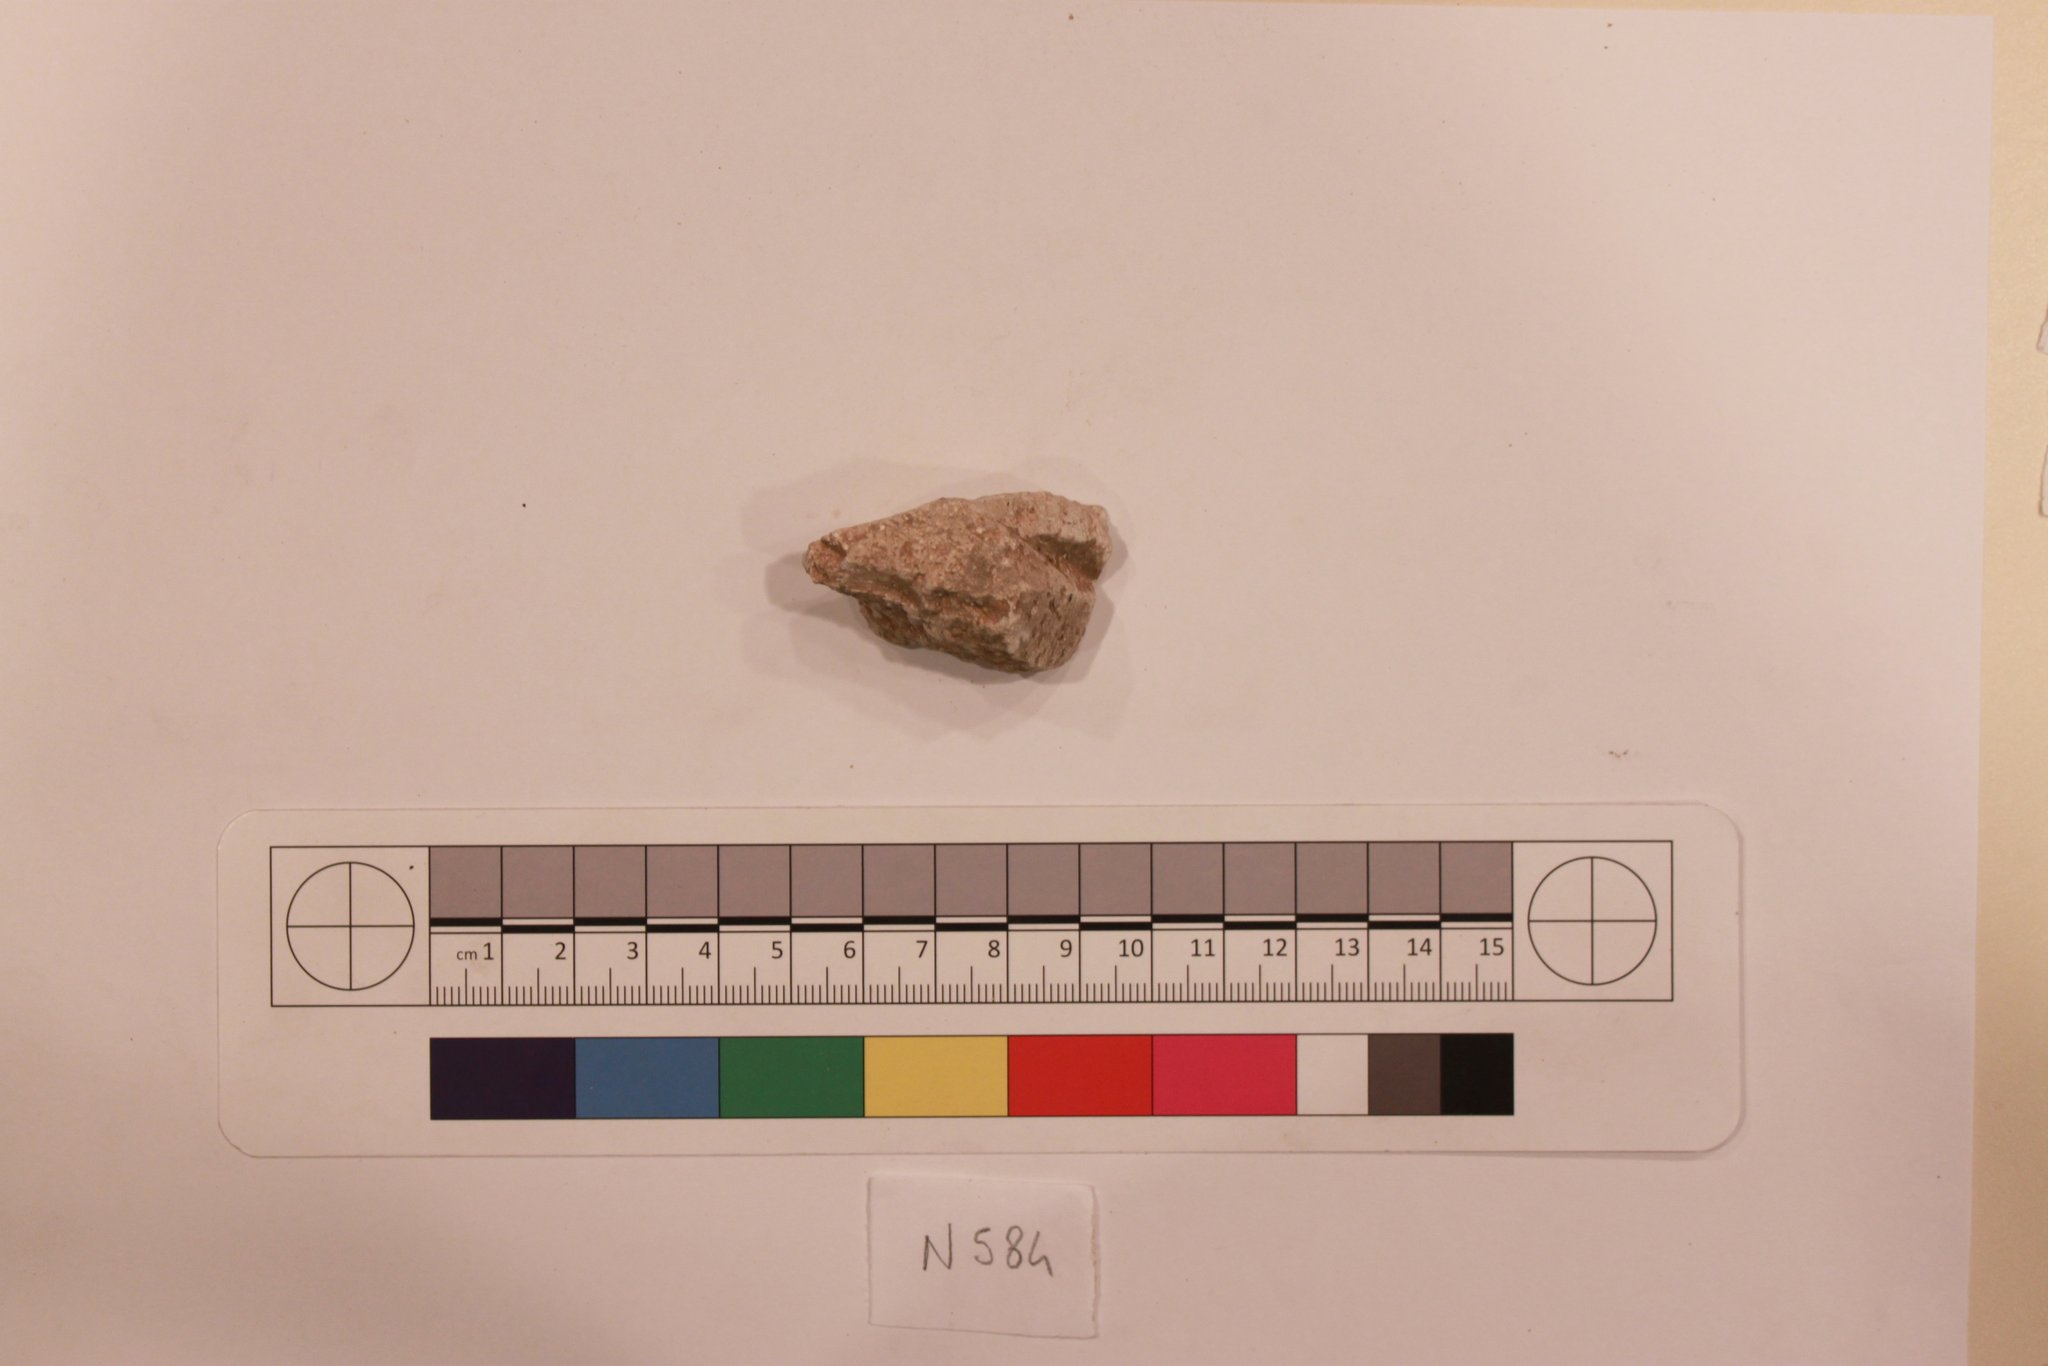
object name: fragment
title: Stucco Fragment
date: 701-1200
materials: plaster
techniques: carving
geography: iran